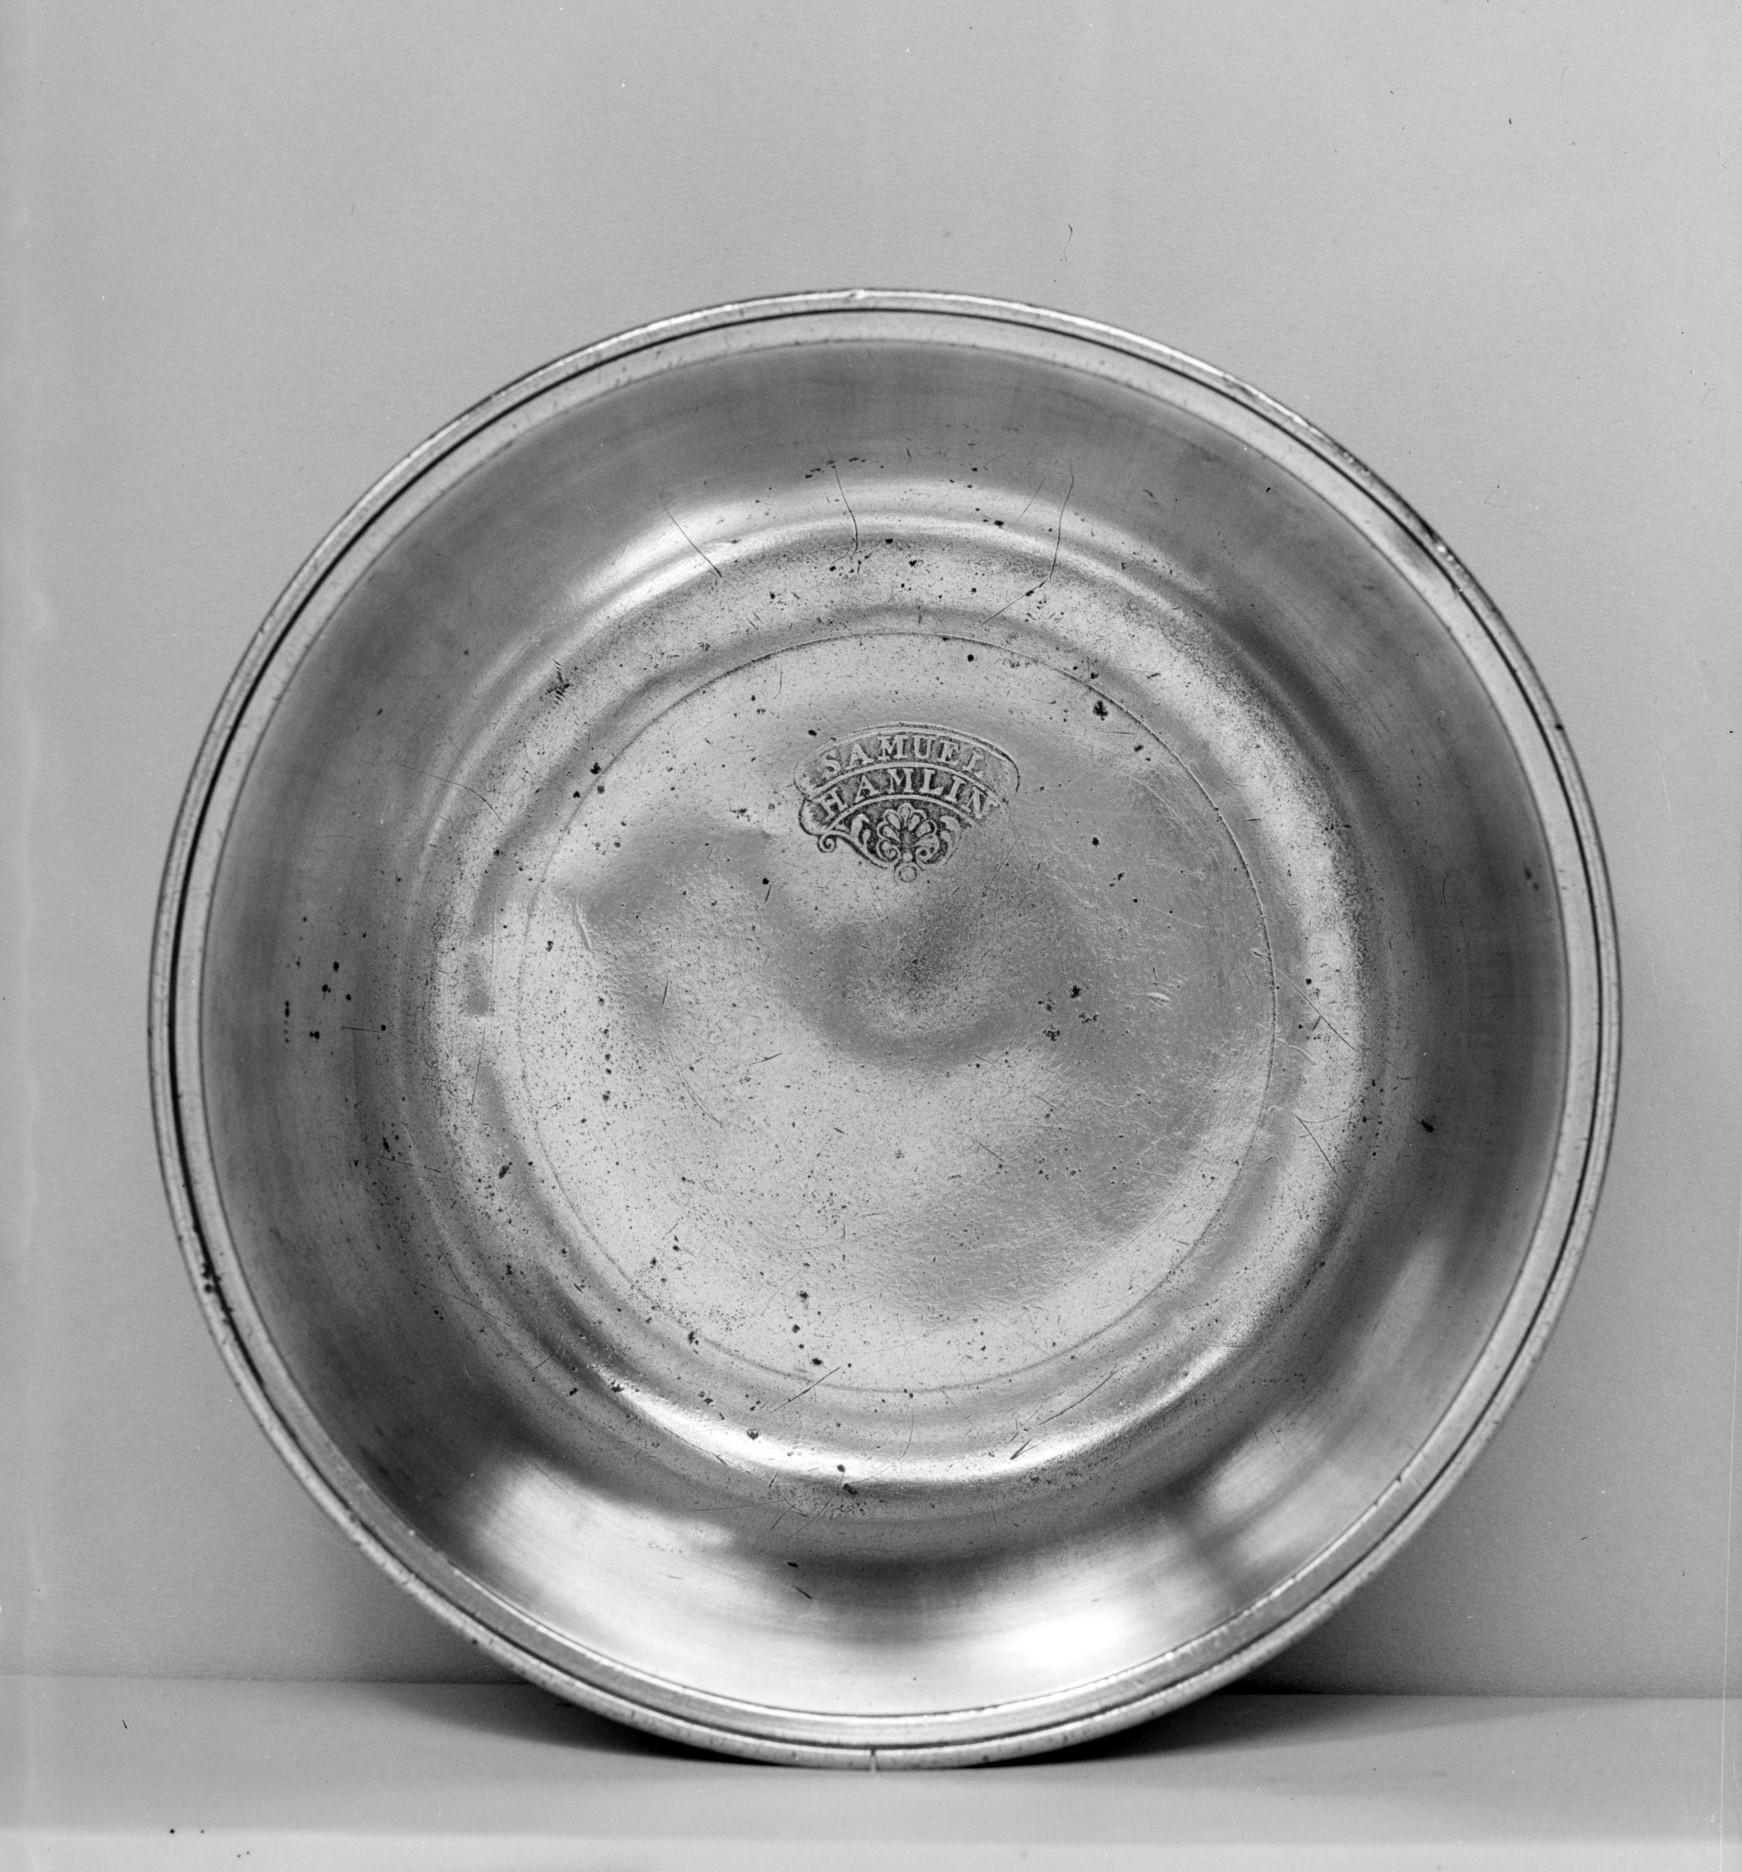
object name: basin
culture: american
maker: samuel hamlin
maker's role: maker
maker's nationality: american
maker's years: 1746-1801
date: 1770-1870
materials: pewter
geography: united states